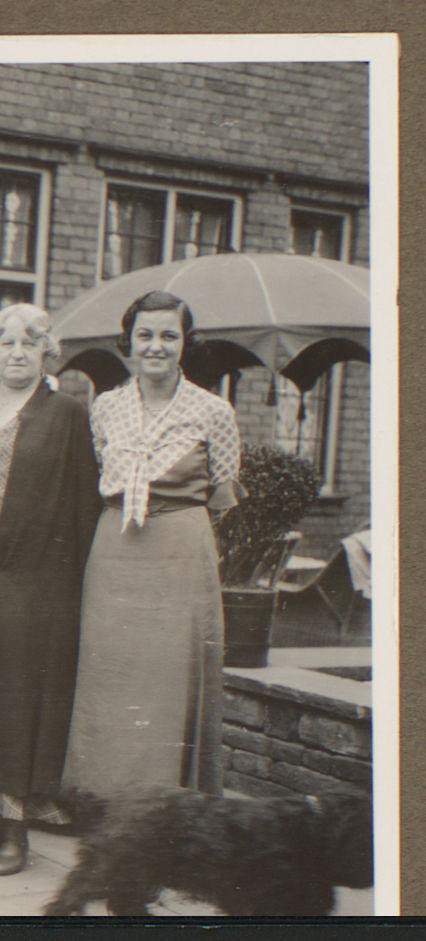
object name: photograph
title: Portret van een winkelende vrouw, Londen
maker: Anonymous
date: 1906-1932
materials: paper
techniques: gelatin silver print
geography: london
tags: historical persons not known by name - bb - woman, marketing, shopping (~ household management), london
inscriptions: inscription: ‘Shopping’